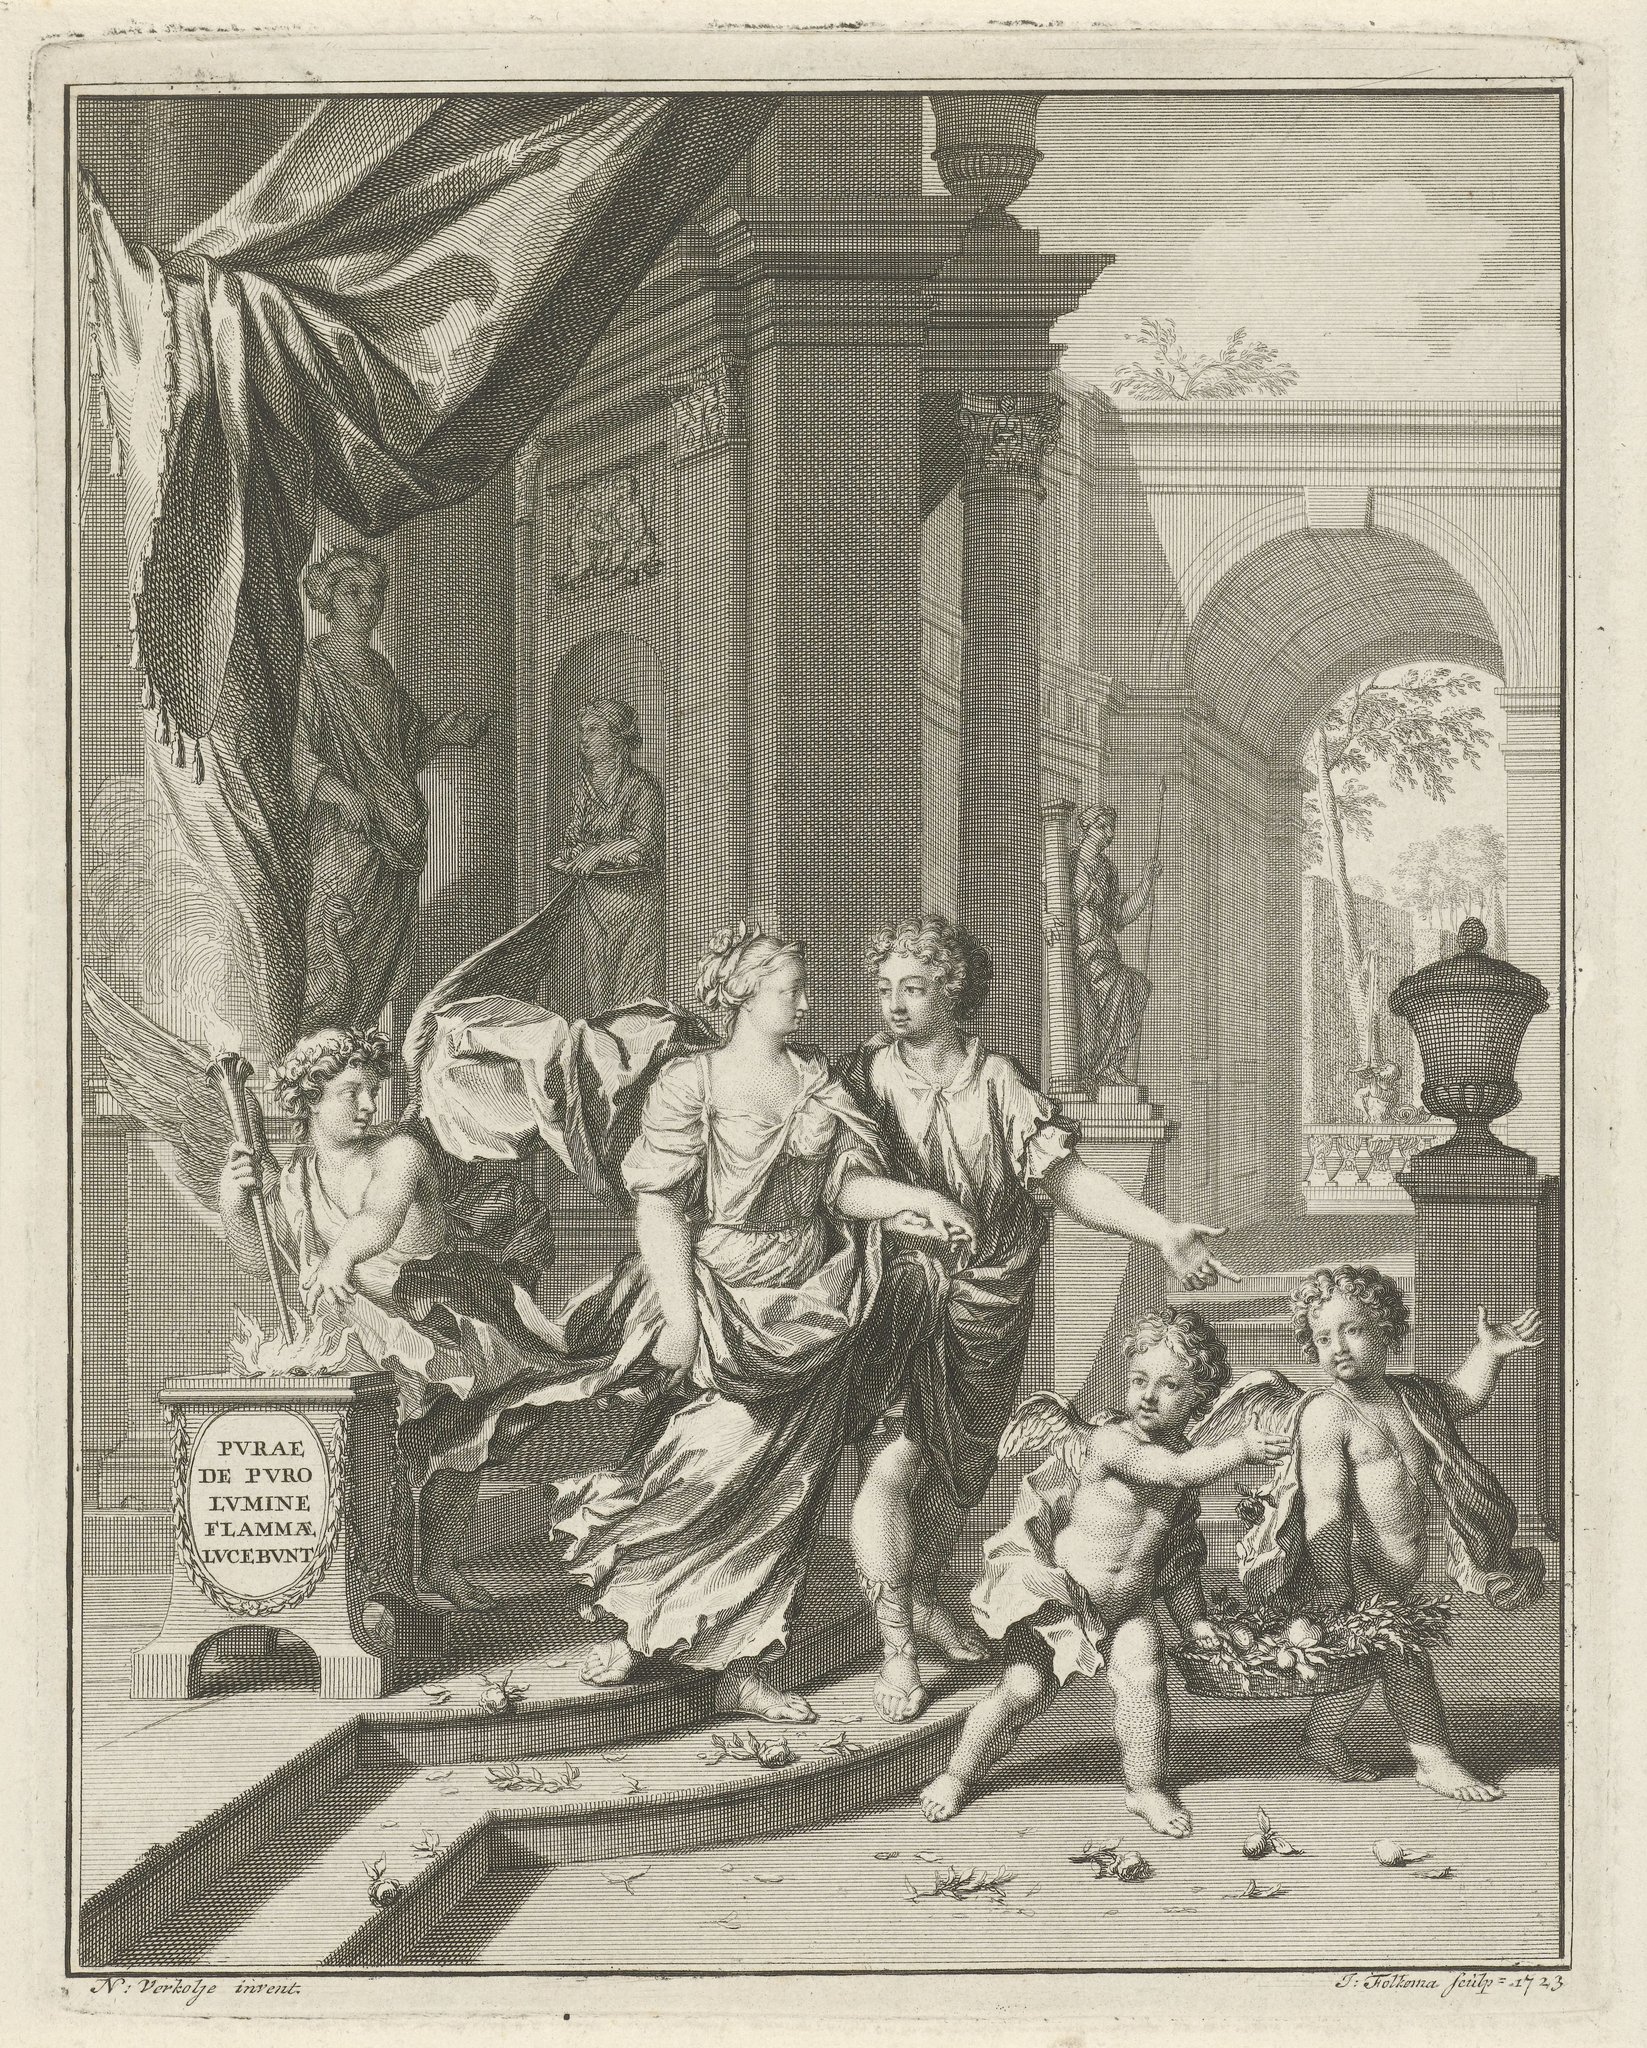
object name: print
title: Allegorie op het huwelijk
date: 1723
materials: paper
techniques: engraving, etching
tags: 'castità matrimoniale', 'fede maritale', 'matrimonio' (ripa), juno iuga, juno pronuba, protectress of marriage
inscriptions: collector's mark: Lugt 240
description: Een liefdespaar loopt hand in hand een tempel uit en wordt nagekeken door Juno, waakster over huwelijk en geboorte. Twee putti lopen voor het paar uit en strooien bloemen. Links staat een engel met een toorts bij een offerzuil waarop de tekst "Purae de Puro Lumine Flammae Lucebunt" staat.